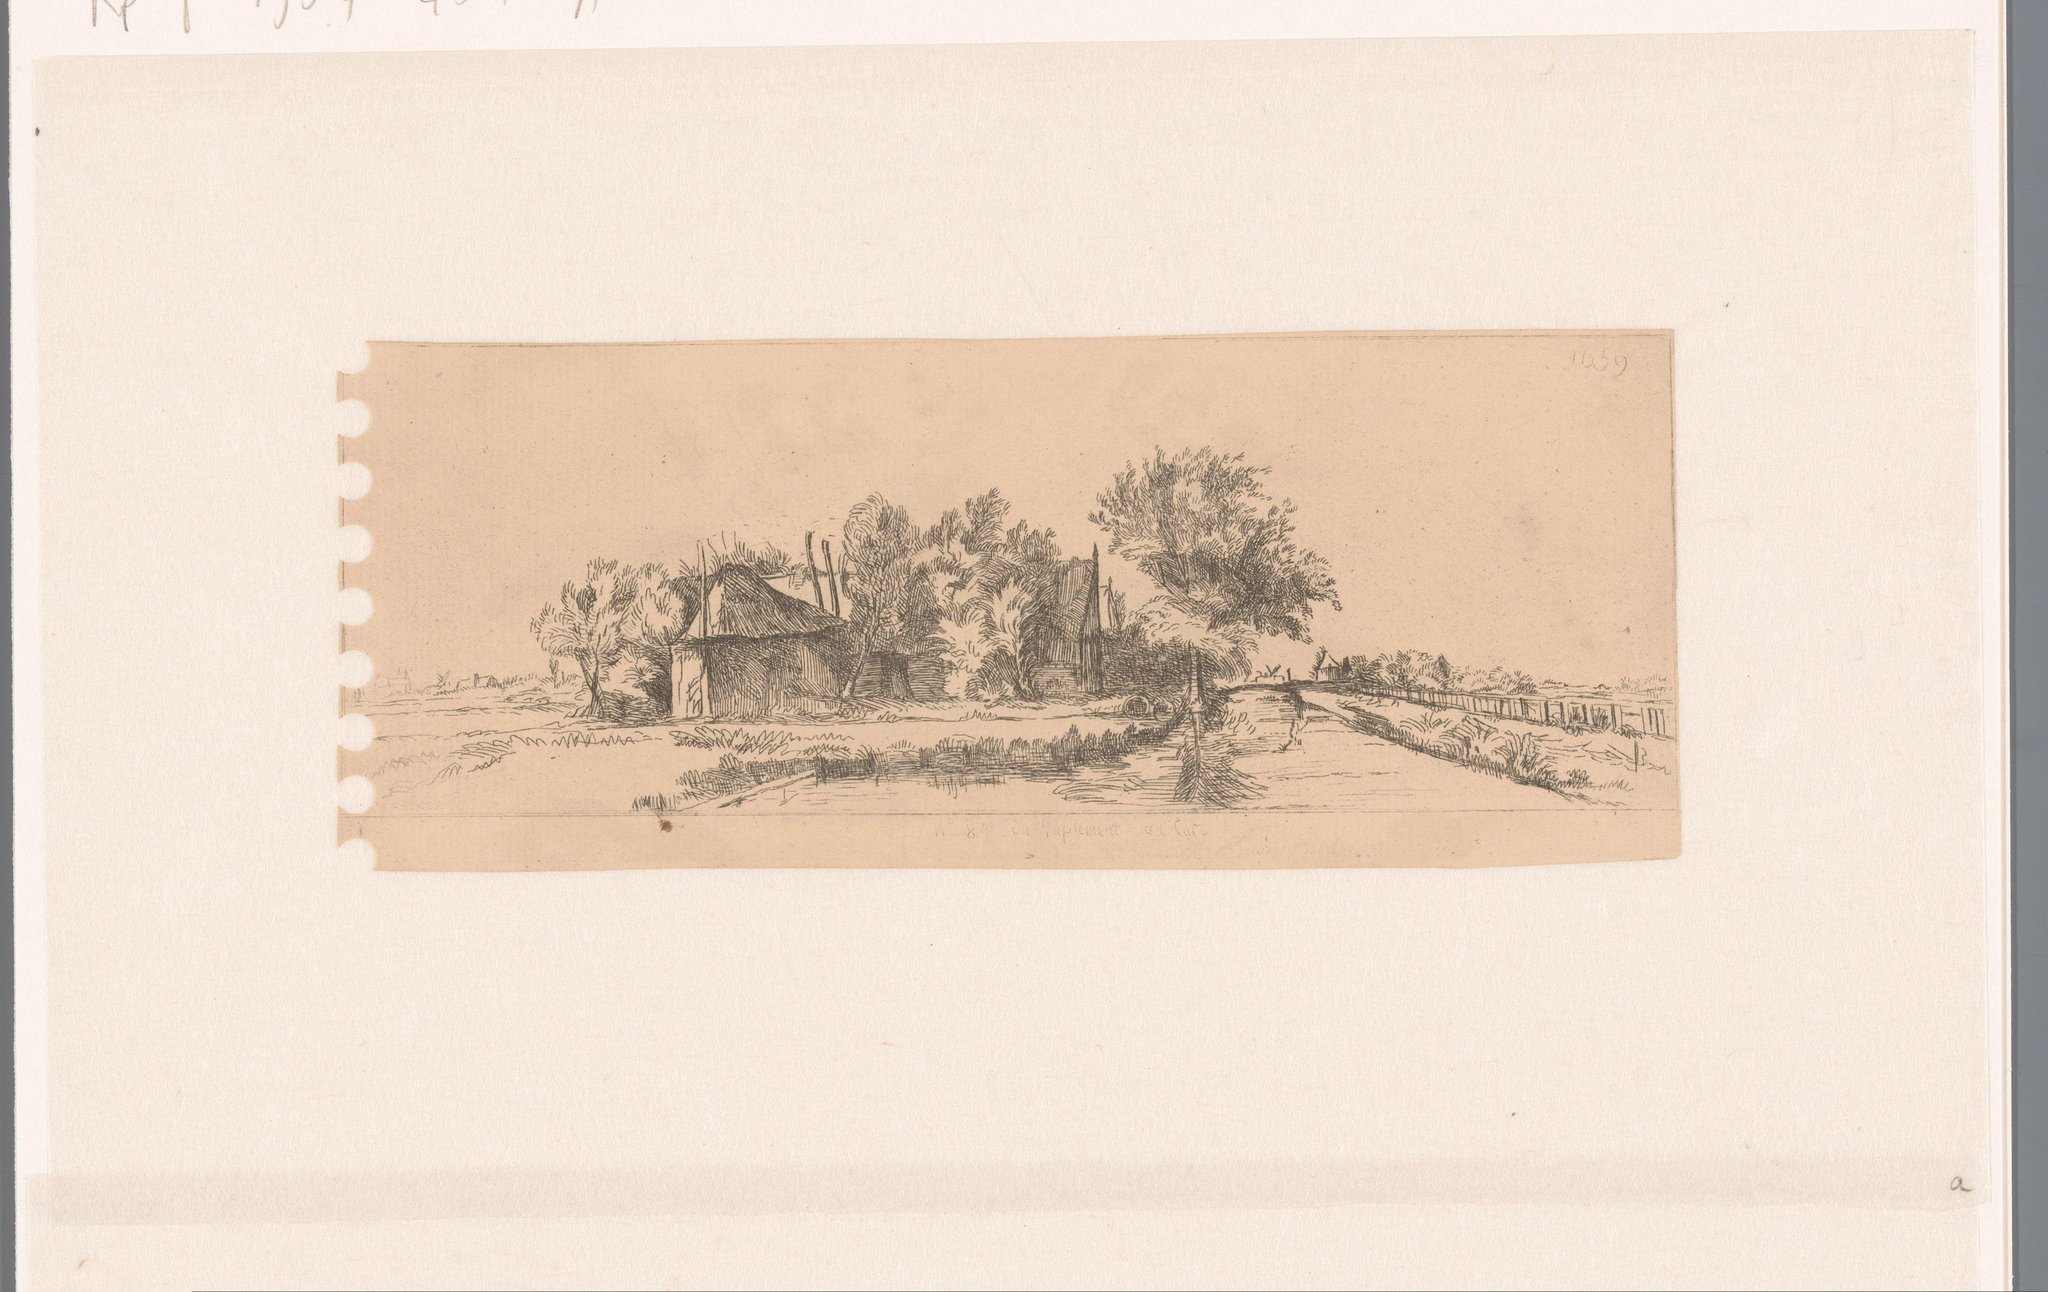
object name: print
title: Landschap met een kanaal en hek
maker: pierre françois basan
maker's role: print maker, publisher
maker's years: 1723-1797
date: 1733-1797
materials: paper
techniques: etching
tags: landscapes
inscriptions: collector's mark: Lugt 2760, collector's mark: Lugt 2228, collector's mark: Lugt 1138c